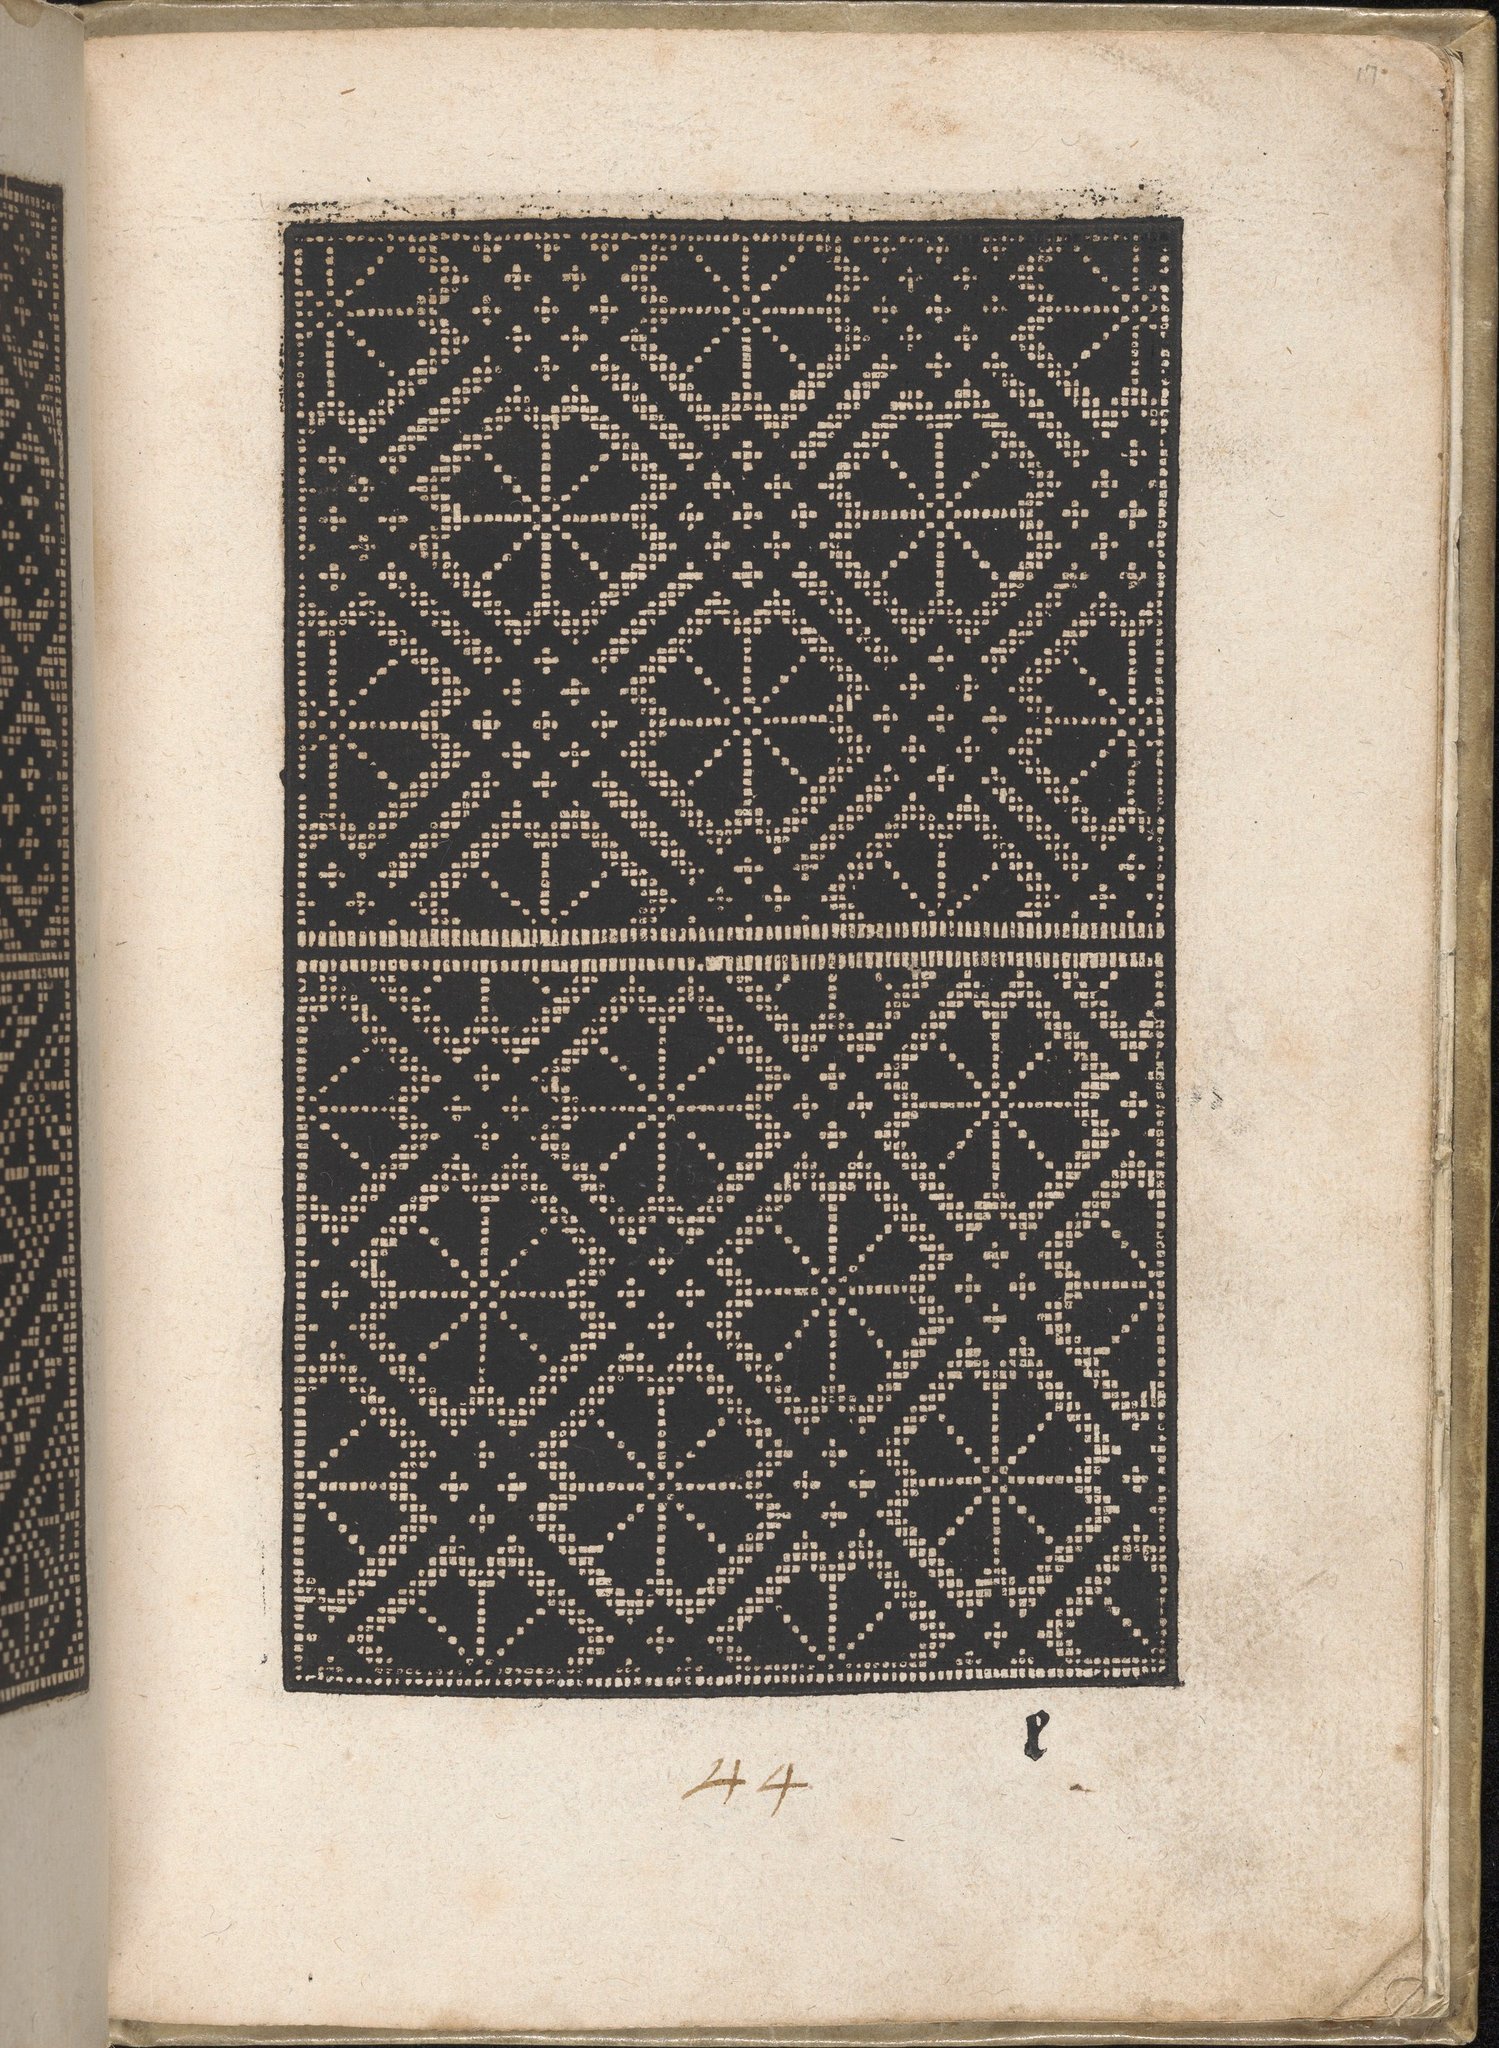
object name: book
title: Page 18r, from "Eyn New Kunstlichboich"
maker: peter quentel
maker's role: publisher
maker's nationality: german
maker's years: 1500-1550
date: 1529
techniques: woodcut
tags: ornament